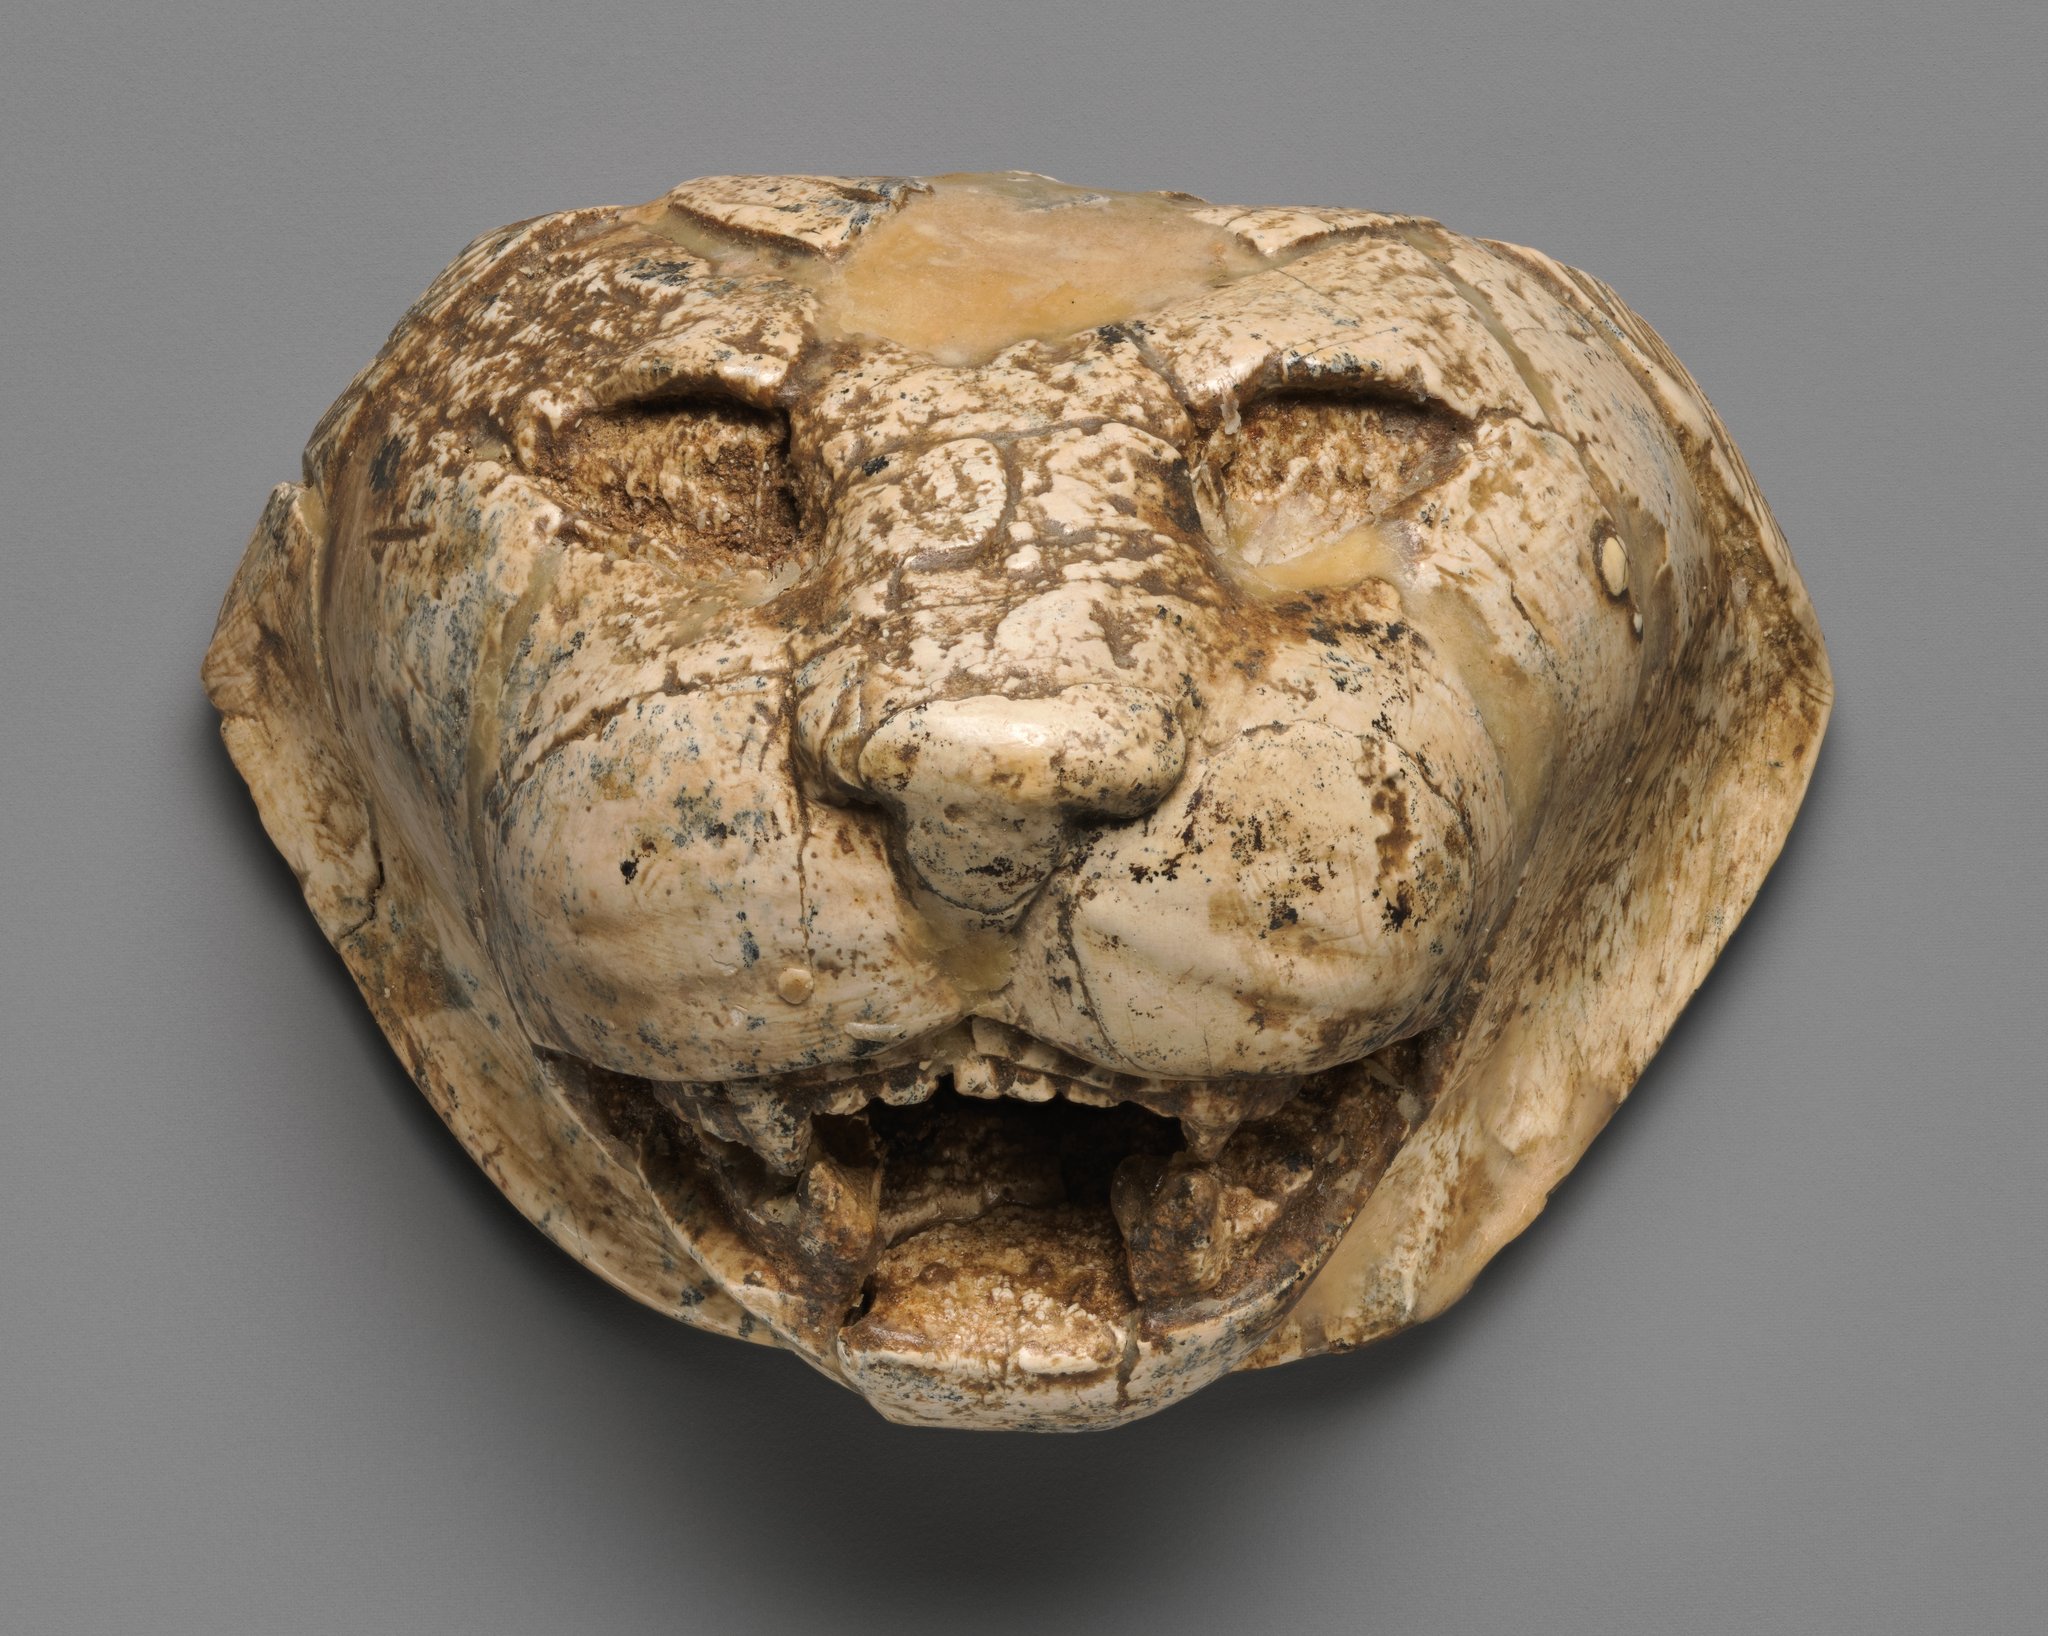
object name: sculpture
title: Lion's head carved in the round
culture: assyrian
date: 900-601 BCE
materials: ivory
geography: mesopotamia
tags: lions